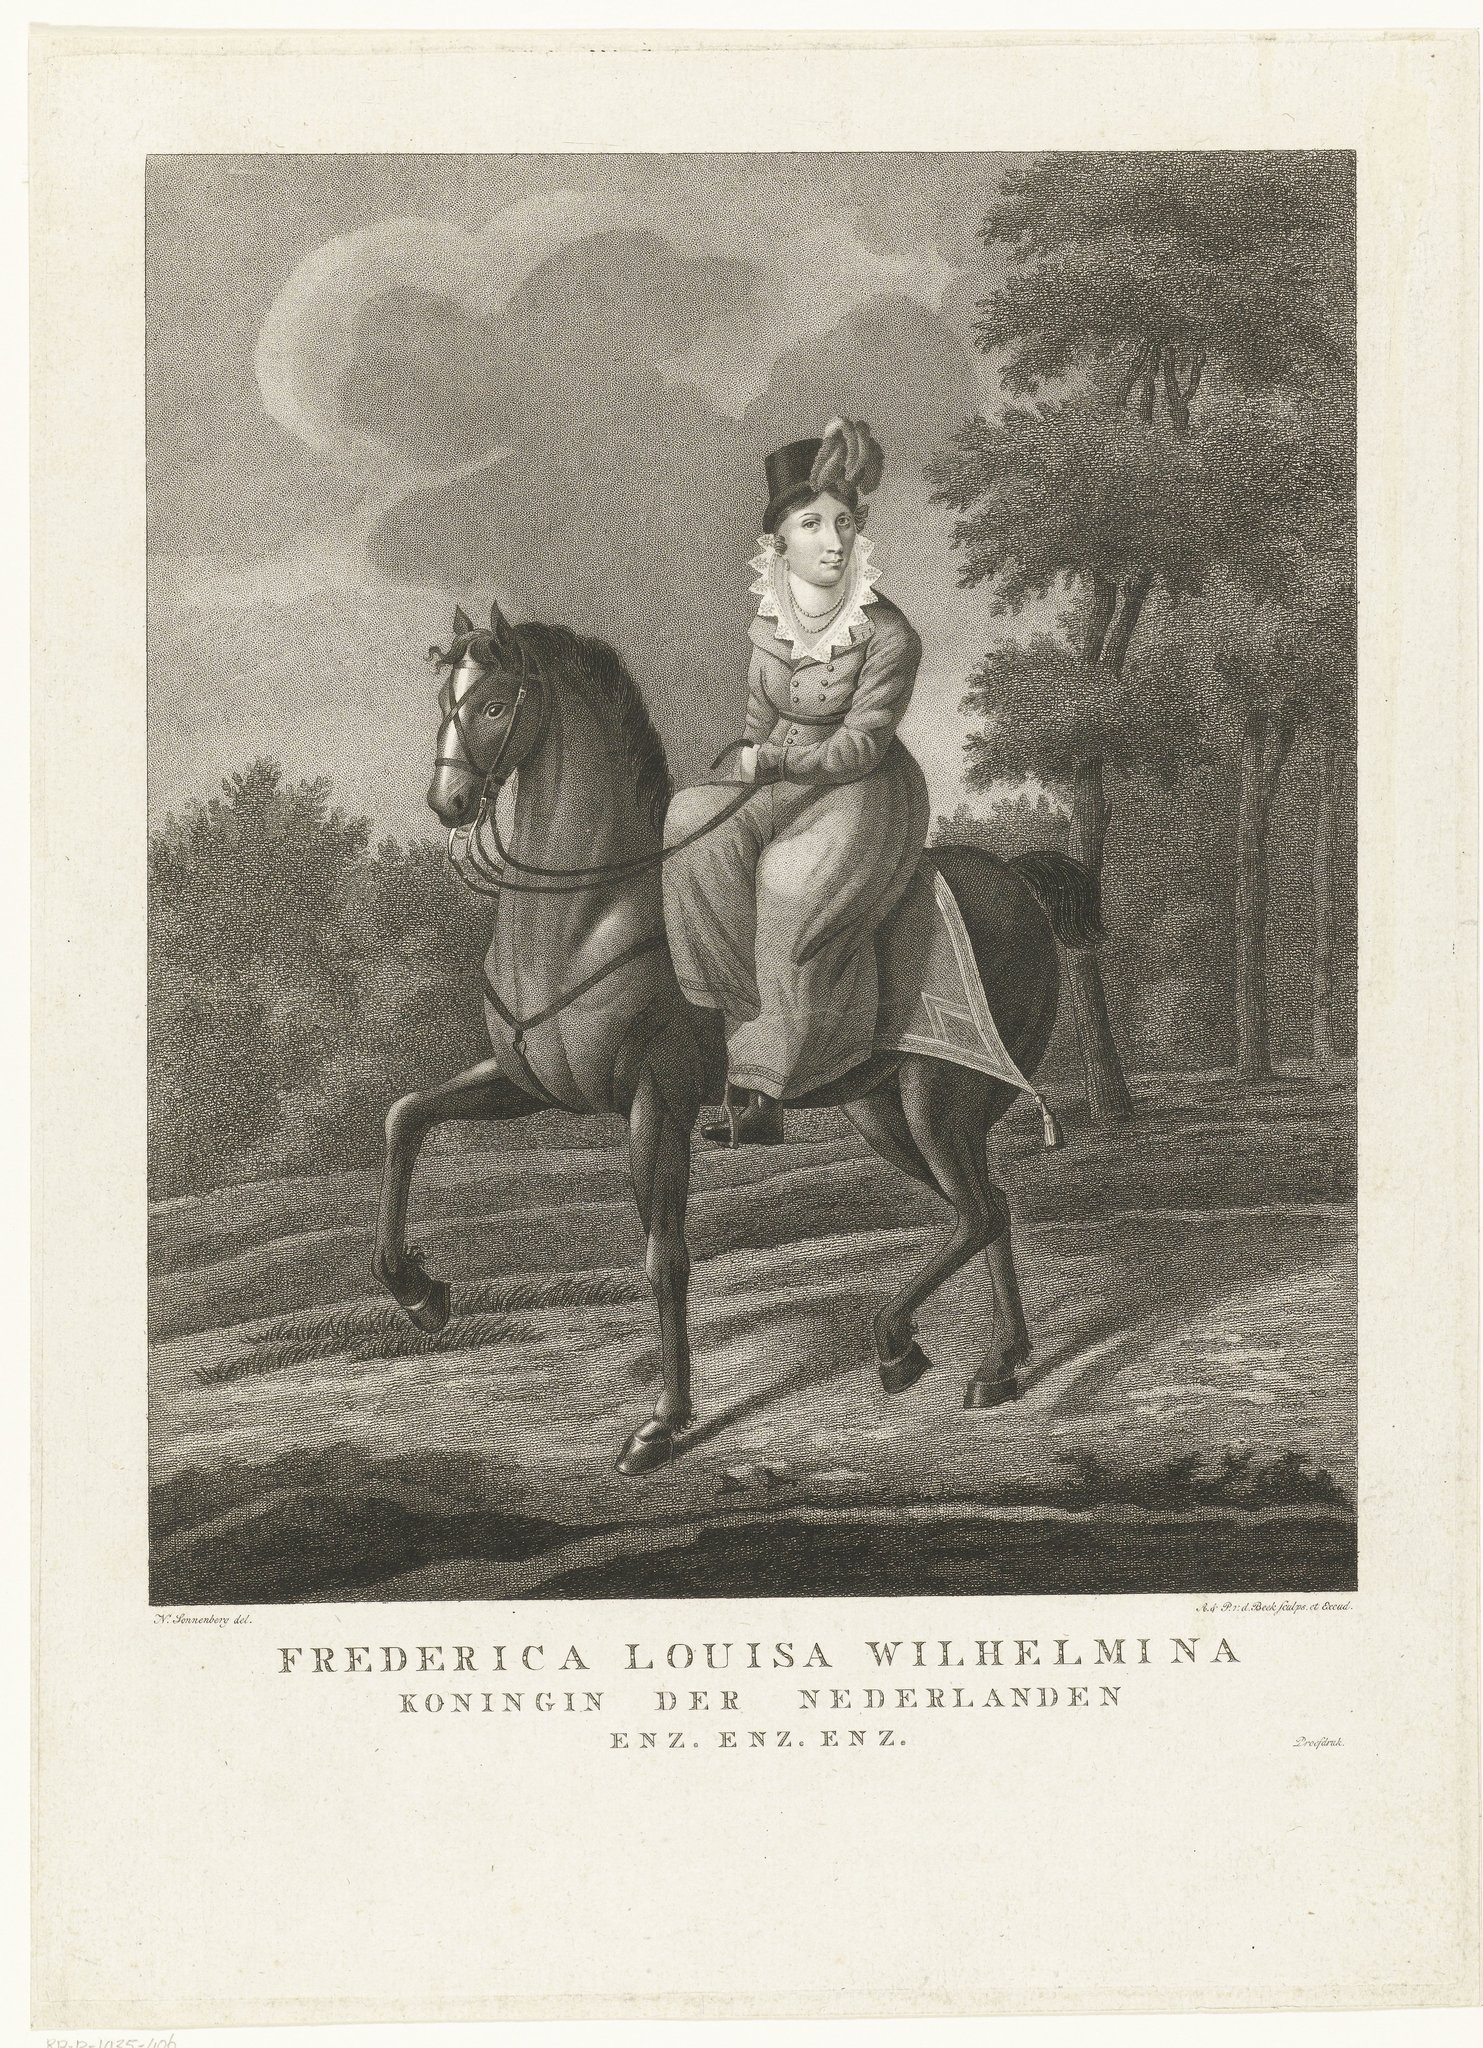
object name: print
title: Frederica Louisa Wilhelmina koningin der Nederlanden enz. enz. enz.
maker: nicolaas sonnenberg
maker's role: draughtsman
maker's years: 1772-1822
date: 1795-1821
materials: paper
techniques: aquatint, etching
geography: netherlands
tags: berlin, the hague, wilhelmina frederica louisa (koningin der nederlanden), equestrian state-portrait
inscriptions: collector's mark: Lugt 2228, collector's mark: Lugt 2760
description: Prent naar tekening van Nicolaas Sonnenberg.